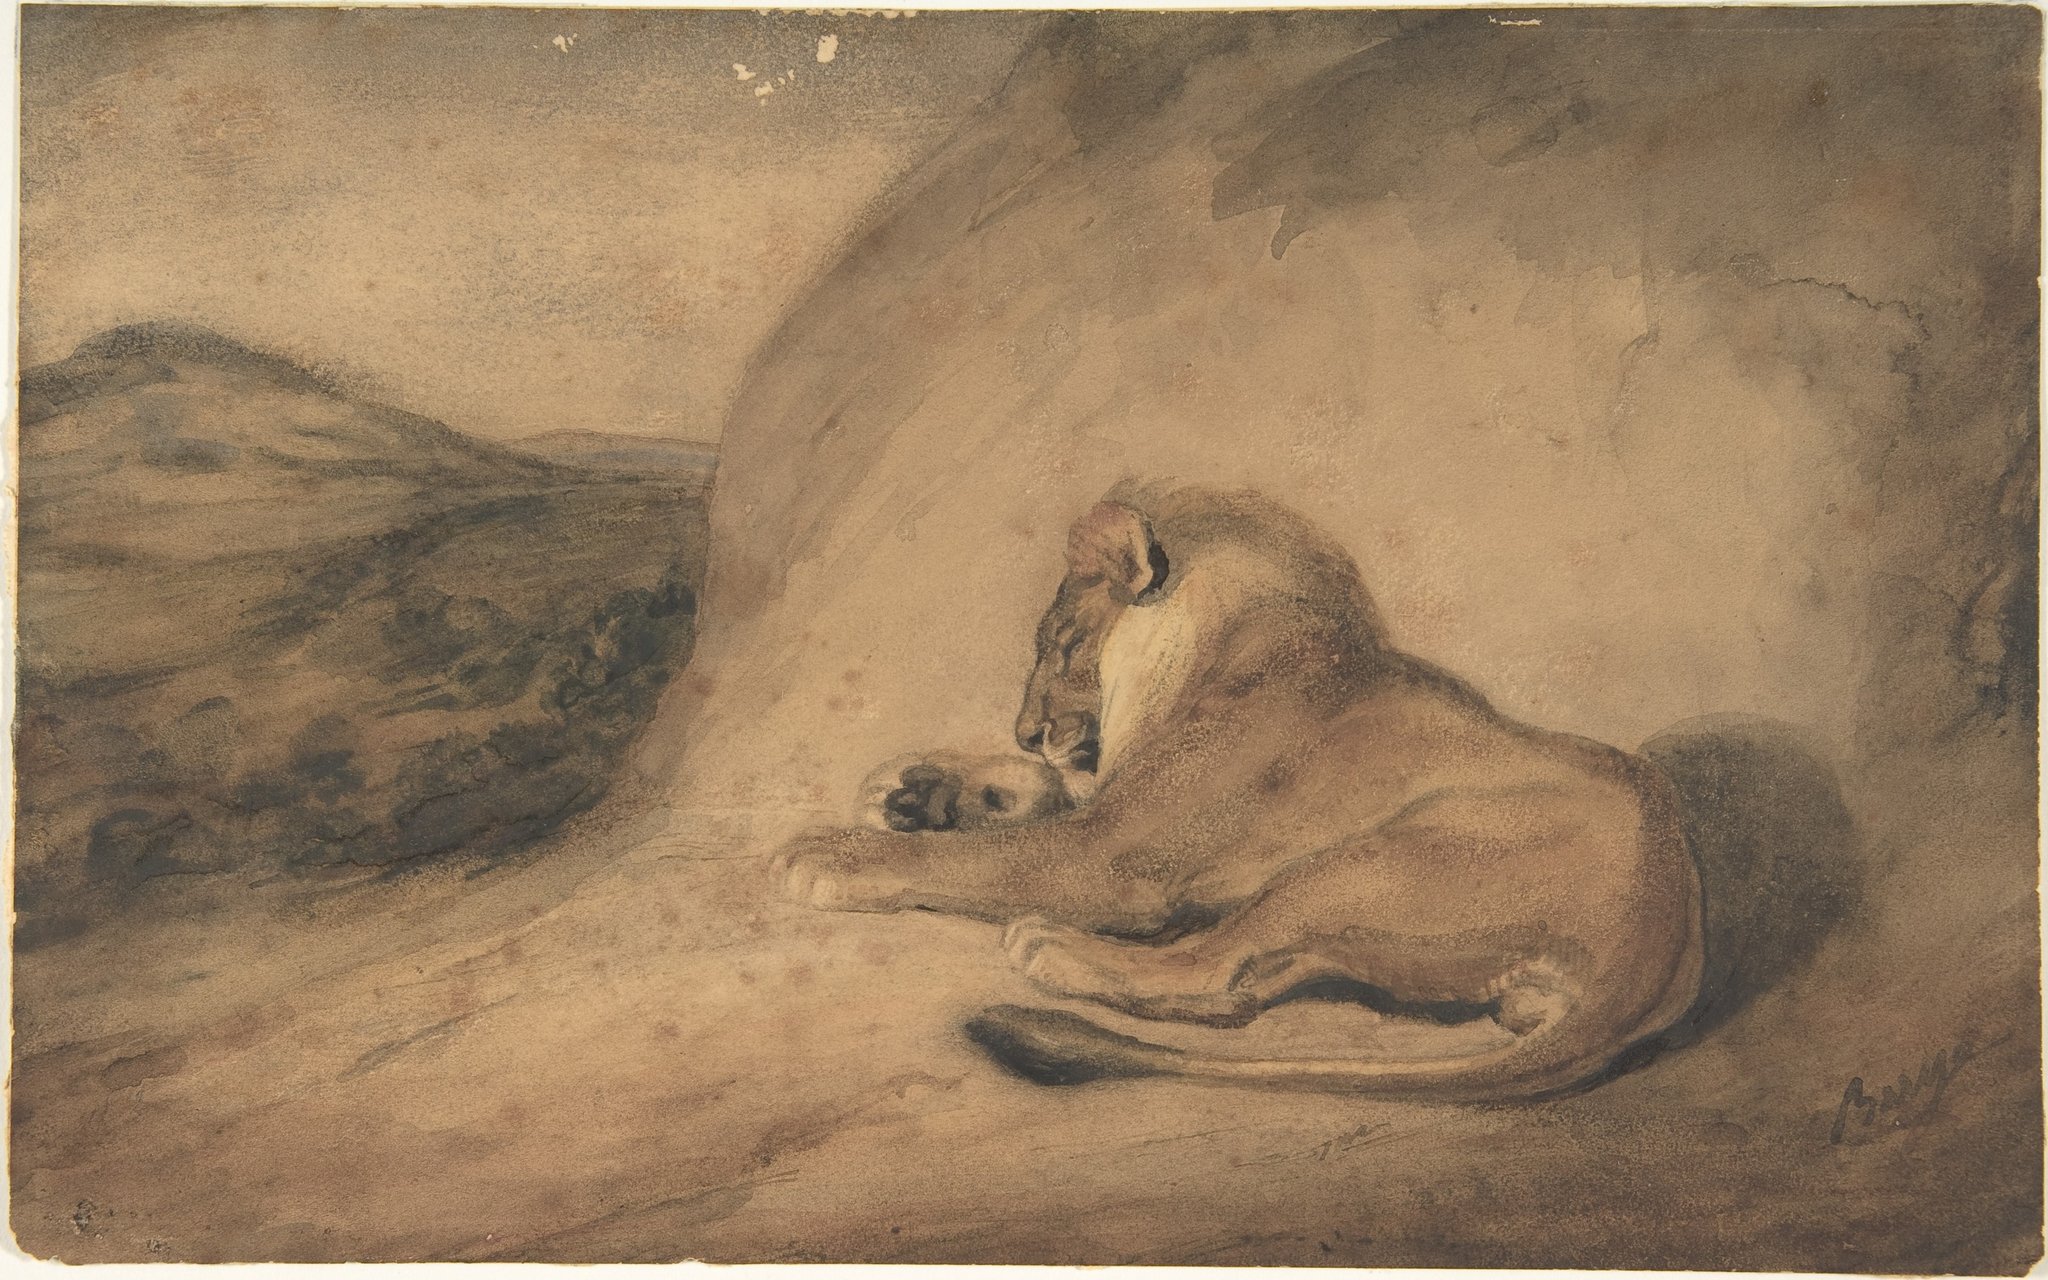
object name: drawing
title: Lion Resting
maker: antoine-louis barye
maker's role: artist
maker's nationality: french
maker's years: 1795-1875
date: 1810-1875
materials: watercolor, paper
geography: france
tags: lions,mountains